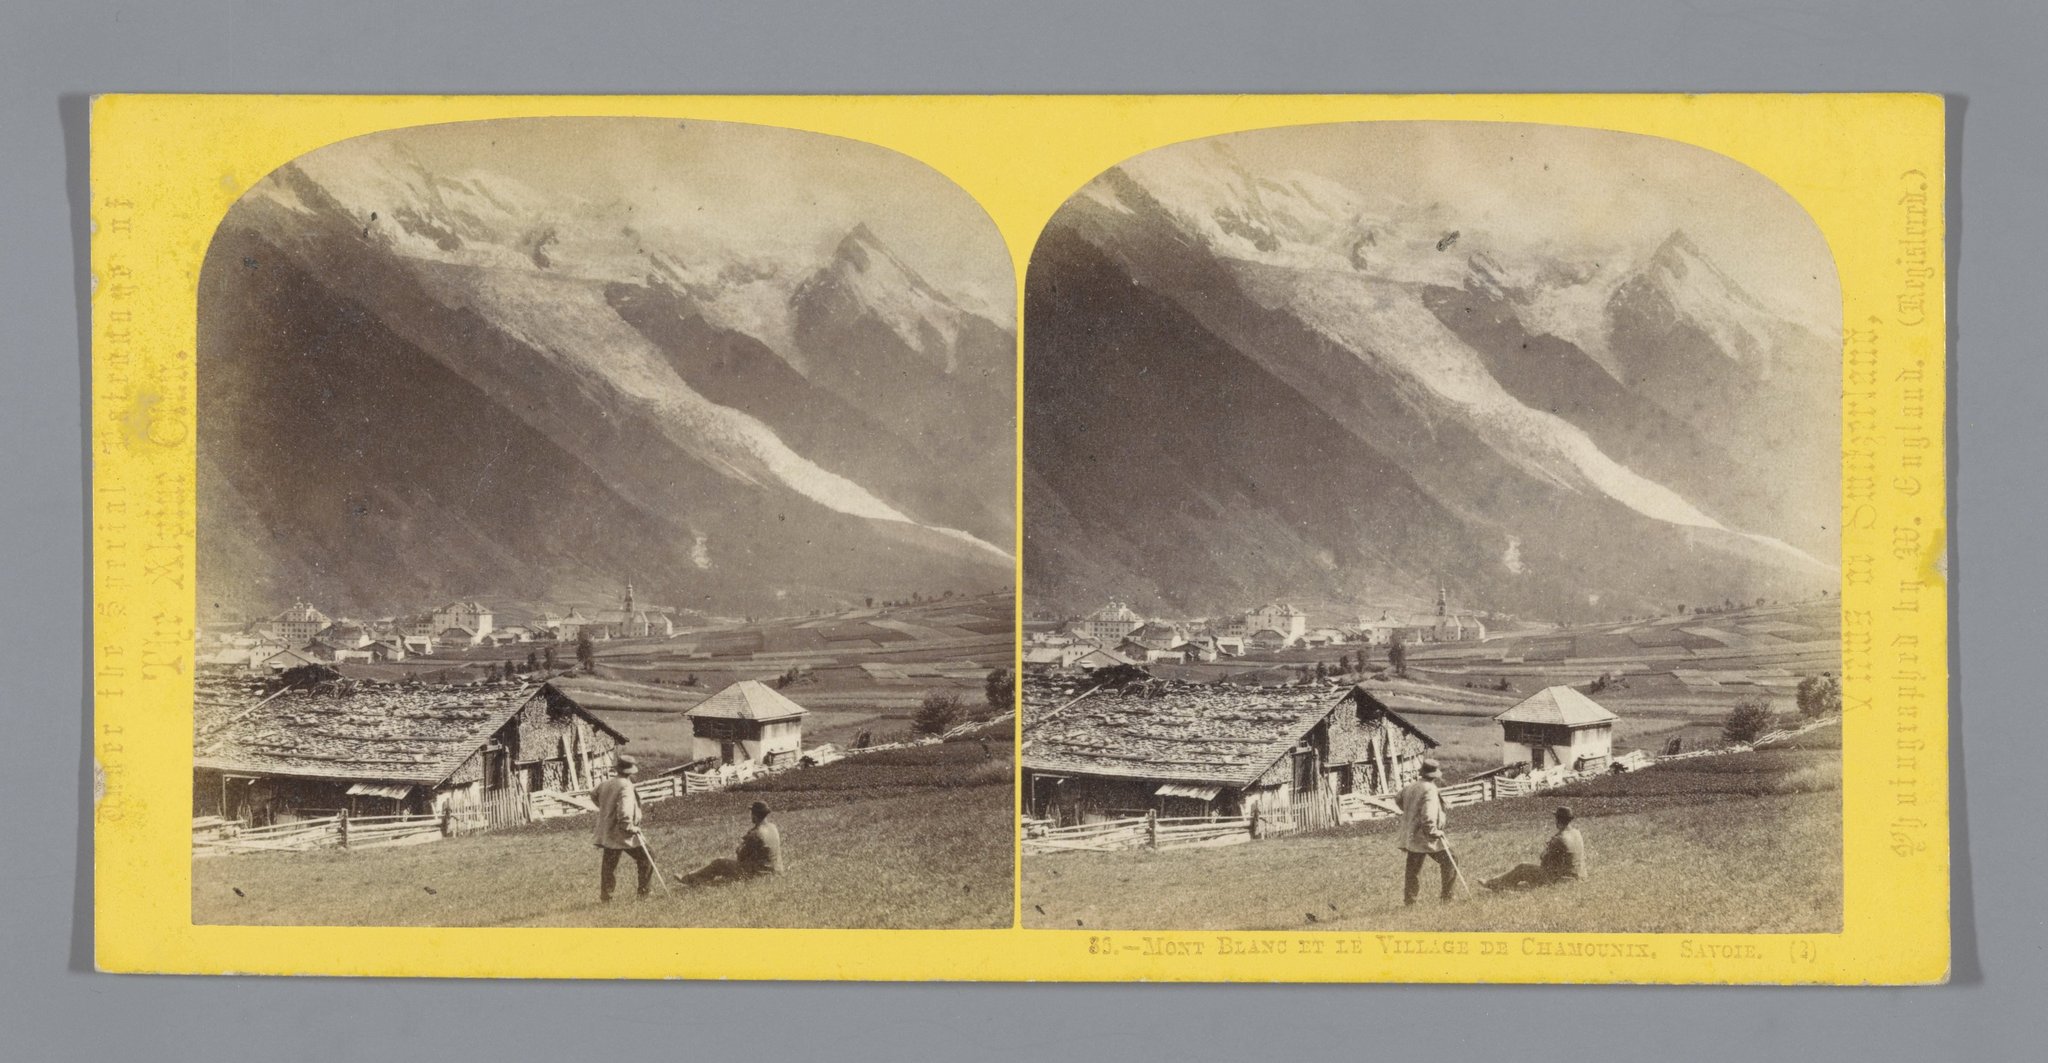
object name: stereograph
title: Mont Blanc et le Village de Chamounix. Savoie. (2)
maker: william england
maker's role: fotograaf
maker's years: 1816-1896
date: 1850-1880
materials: cardboard, photographic support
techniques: albumen print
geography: haute-savoie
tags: dale, valley, city-view in general; 'veduta', mountains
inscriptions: inscription: ‘Views of Switzerland, photographed by W. England. (Registered) Under the Special Patronage of the Alpine Club.’, number: ‘36.’